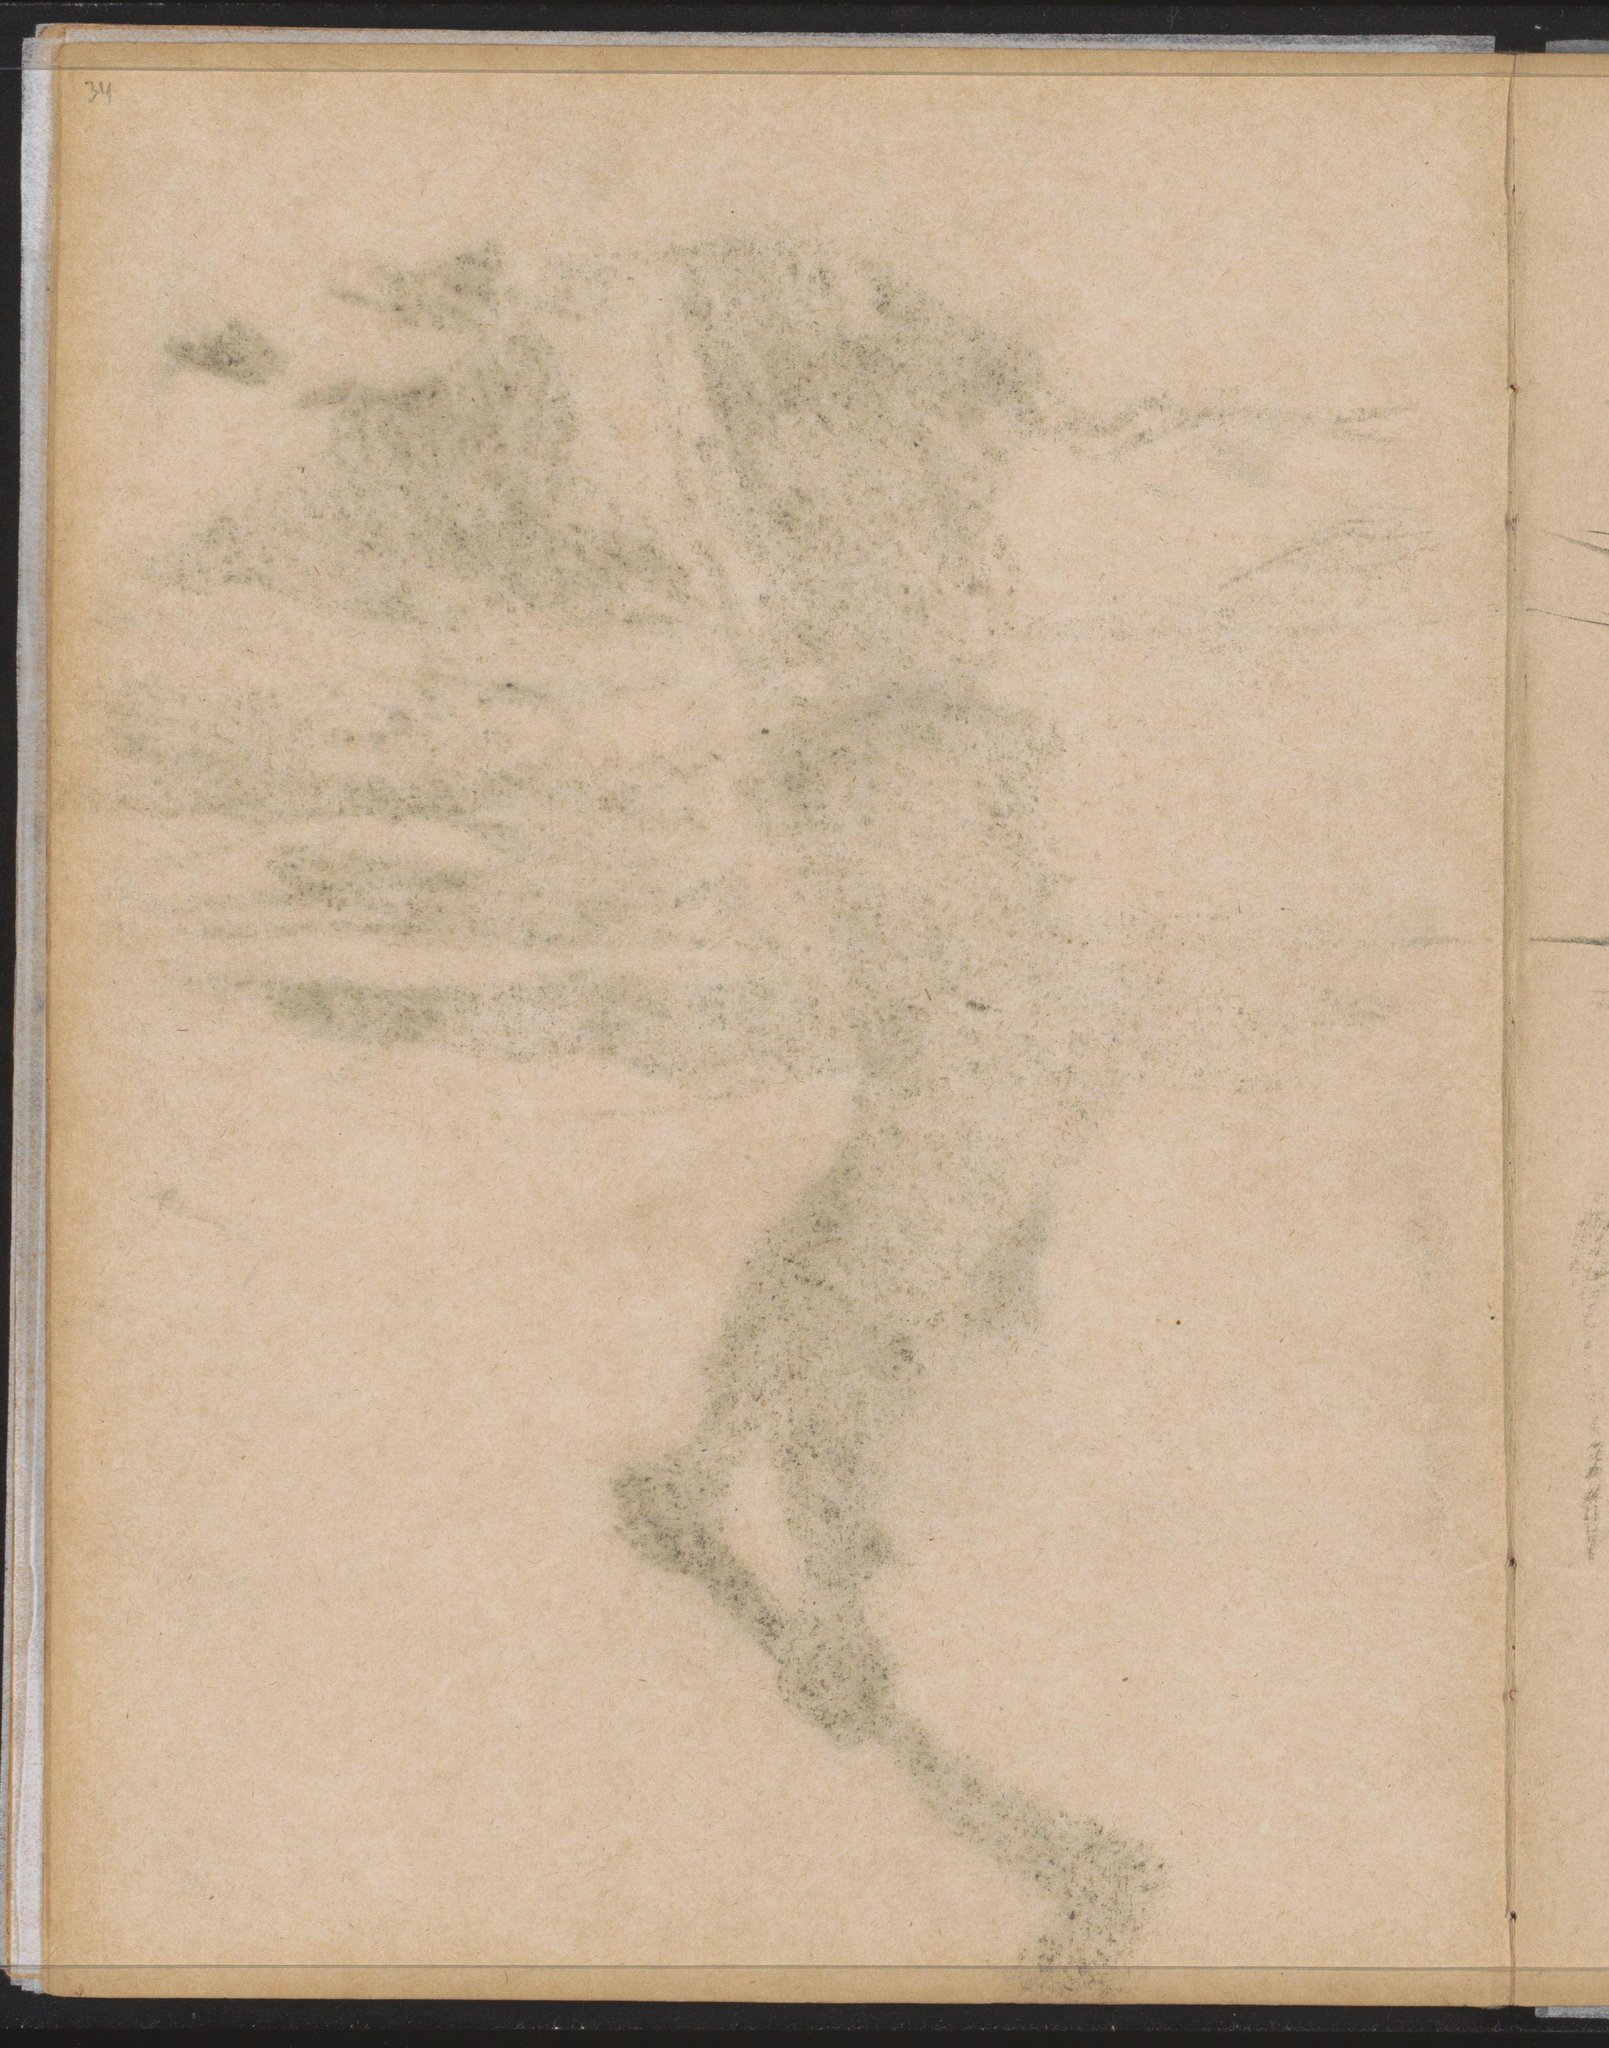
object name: sketchbook leaf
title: Abklatsch van de krijttekening op pagina 35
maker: willem witsen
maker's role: draughtsman, painter, print maker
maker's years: 1860-1923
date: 1884-1891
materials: paper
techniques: printmaking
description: Pagina 34 uit een schetsboek met 49 bladen.